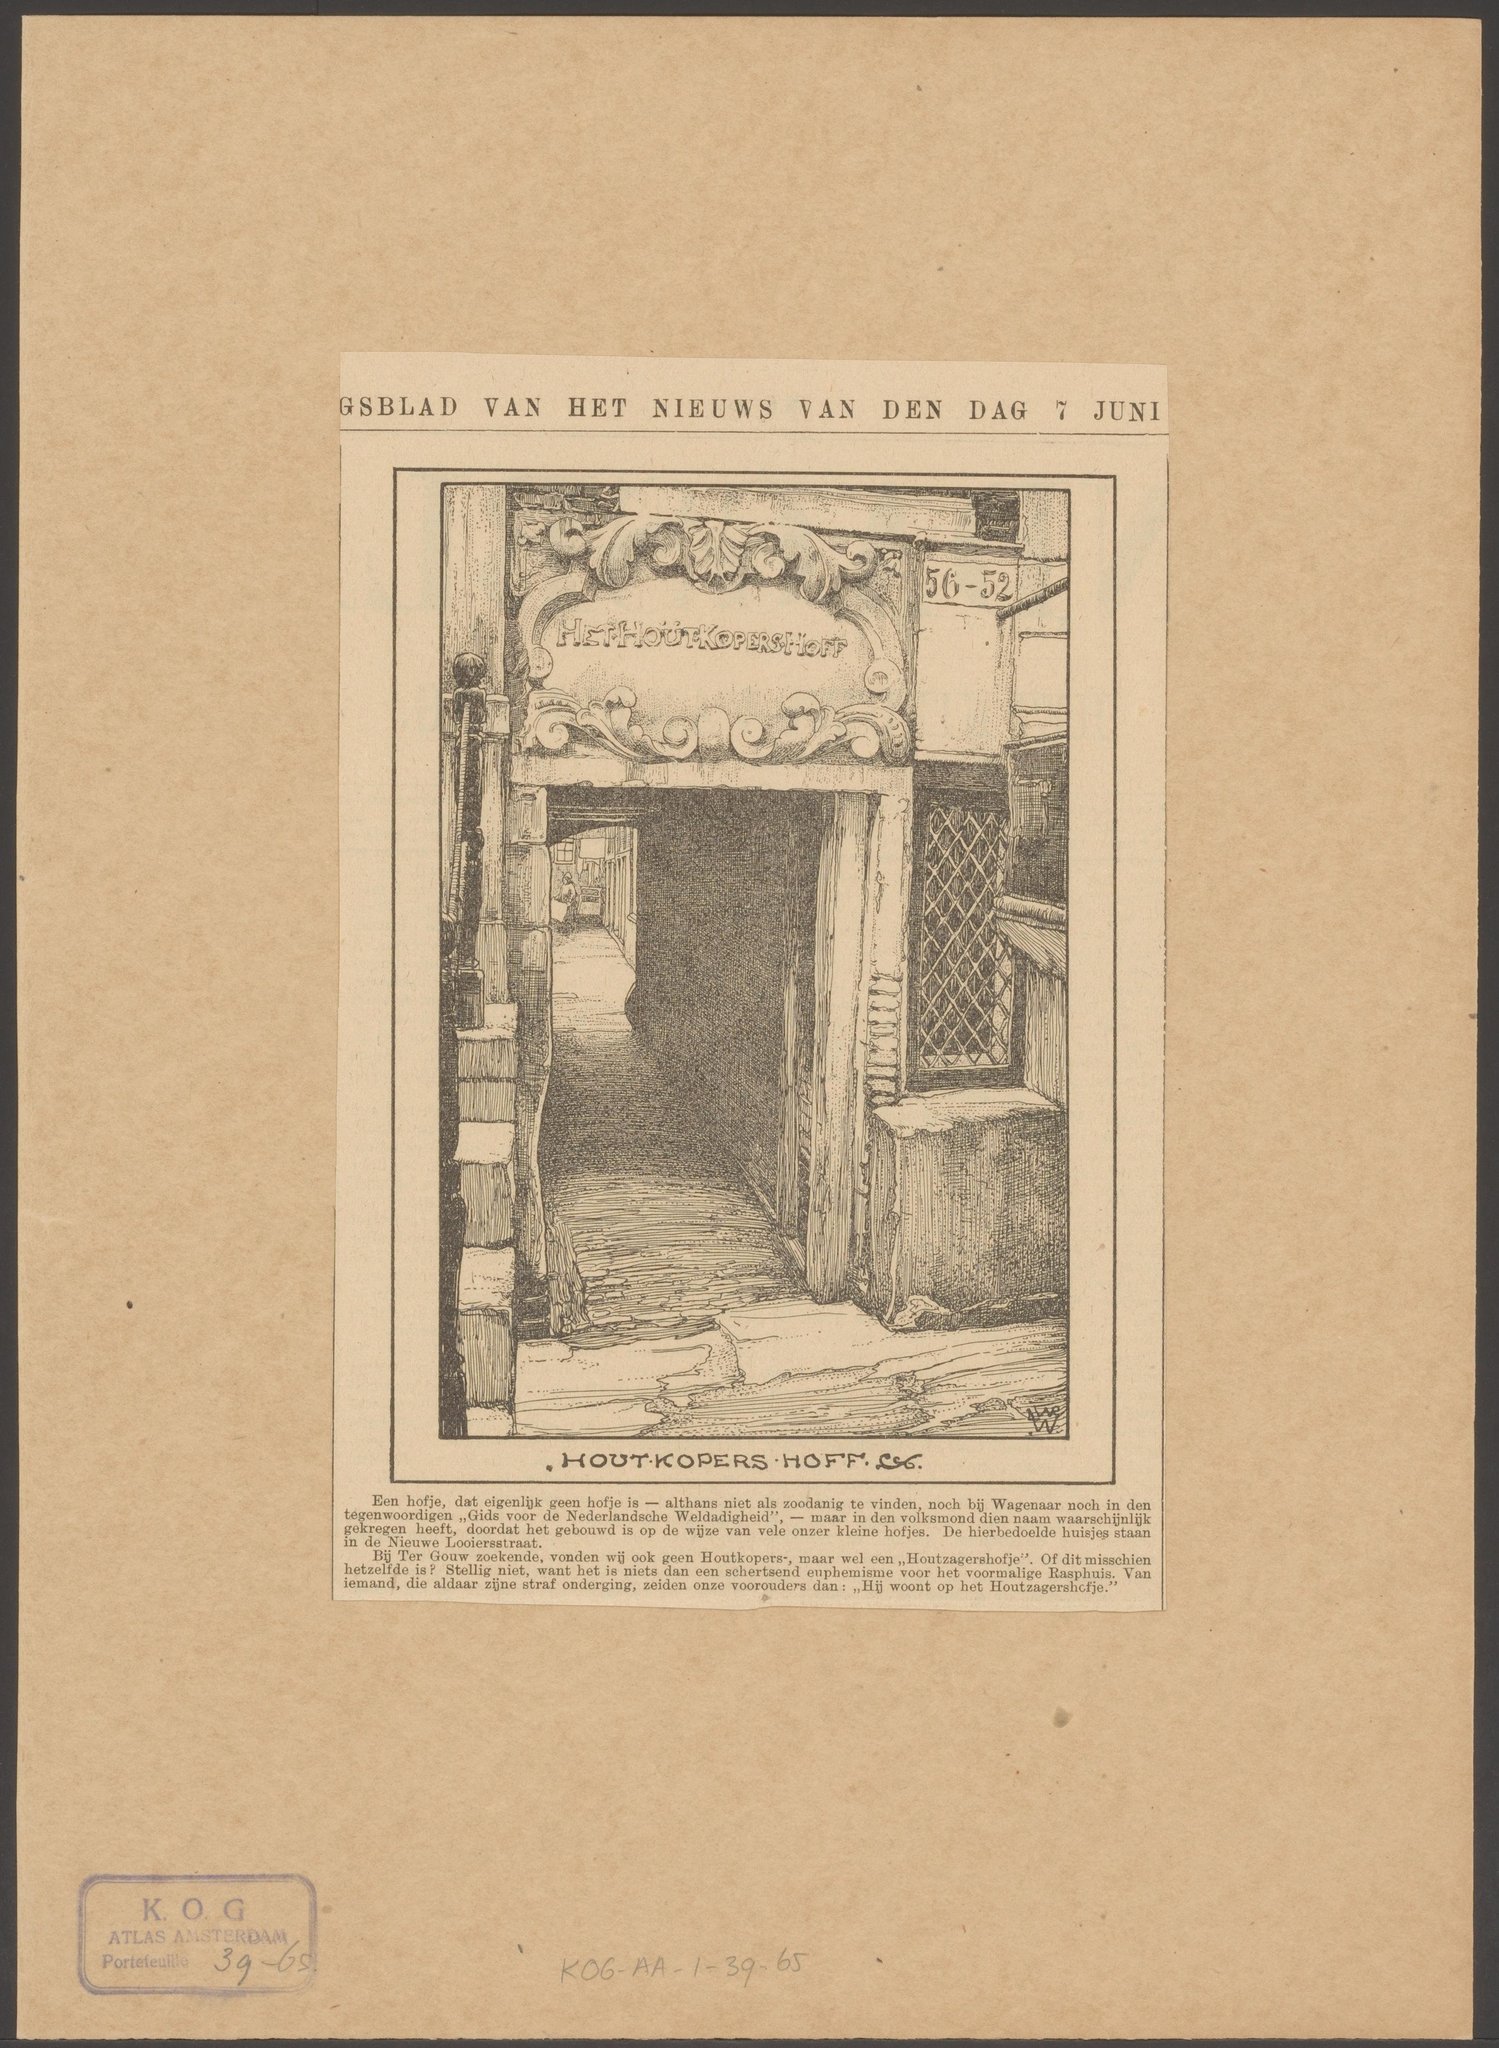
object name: photomechanical print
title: Houtkopers Hoff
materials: paper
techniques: letterpress printing, line block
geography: amsterdam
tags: alms-house (dutch: 'hofje'), gate, entrance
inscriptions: collector's mark: Lugt 1641b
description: Onderwerpsrubriek binnen de Atlas Amsterdam: Armwezen en liefdadige instellingen: III. Verschillende gestichten en instellingen / Hofjes: Hodshon-Dedelhofje - Hofje op de Palmgracht - Houtkopershofje.